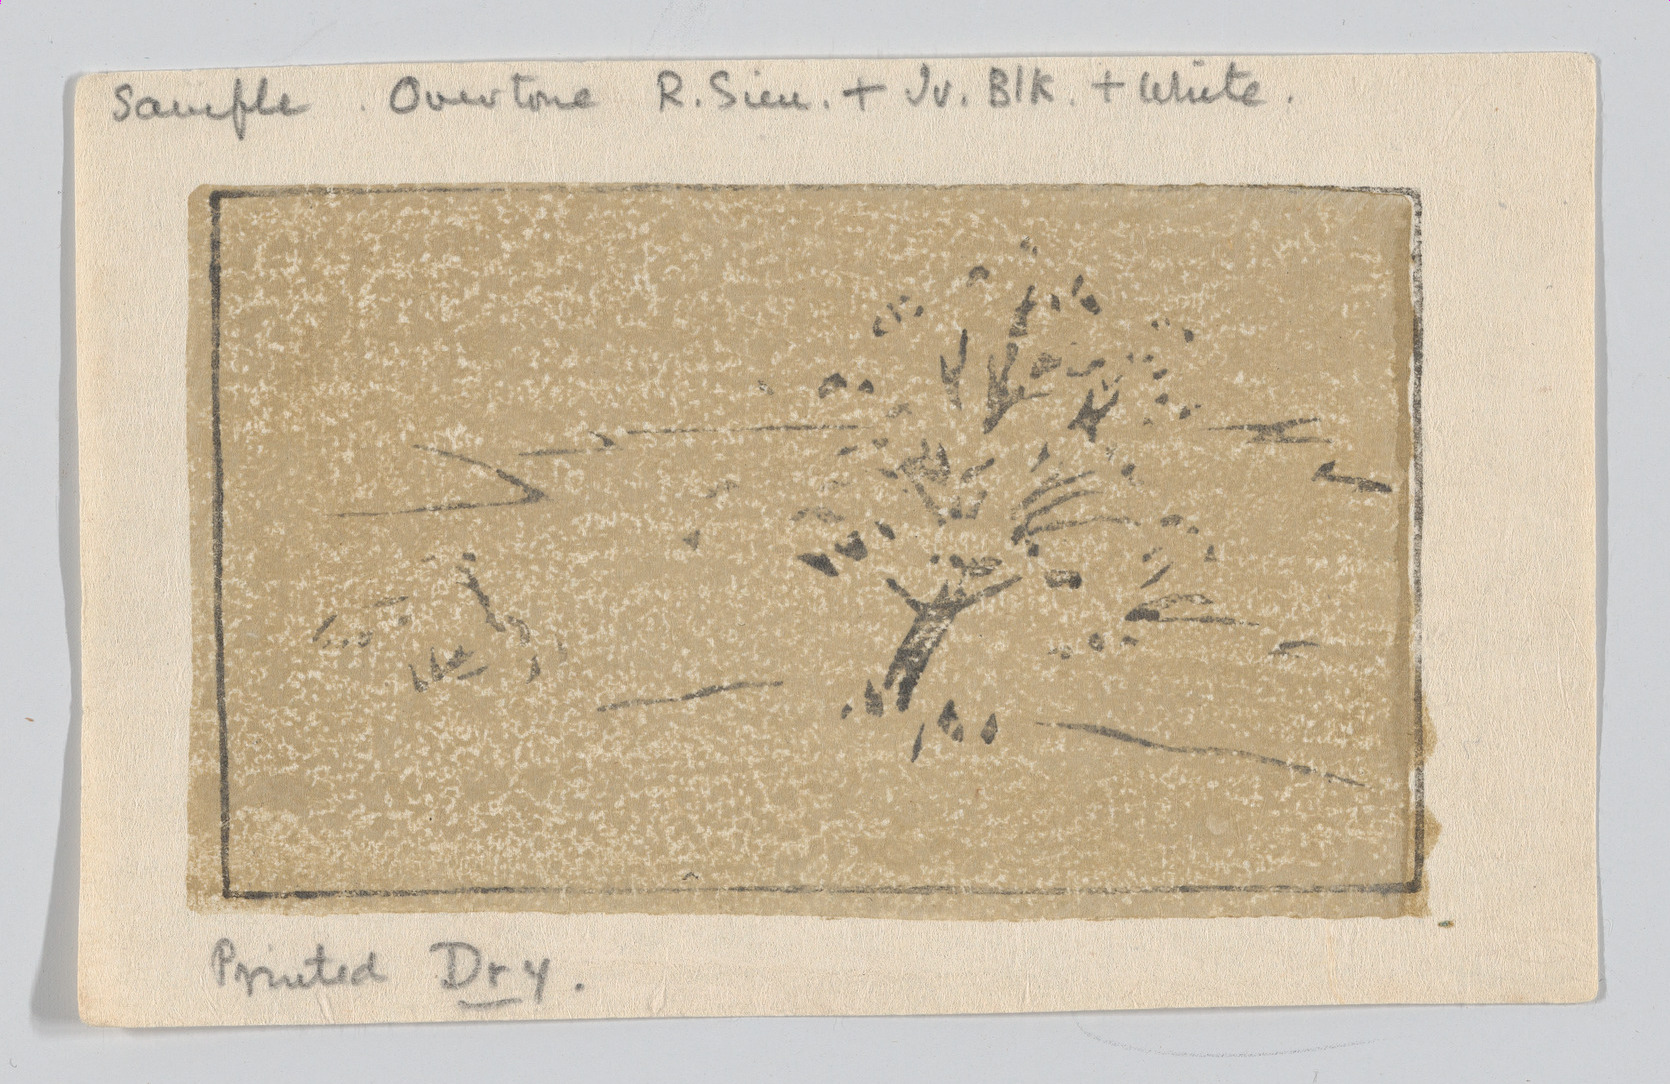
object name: woodcut, print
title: Nabby's Point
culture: american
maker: arthur wesley dow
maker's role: artist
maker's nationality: american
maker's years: 1857-1922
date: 1913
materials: paper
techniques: woodcut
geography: united states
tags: trees